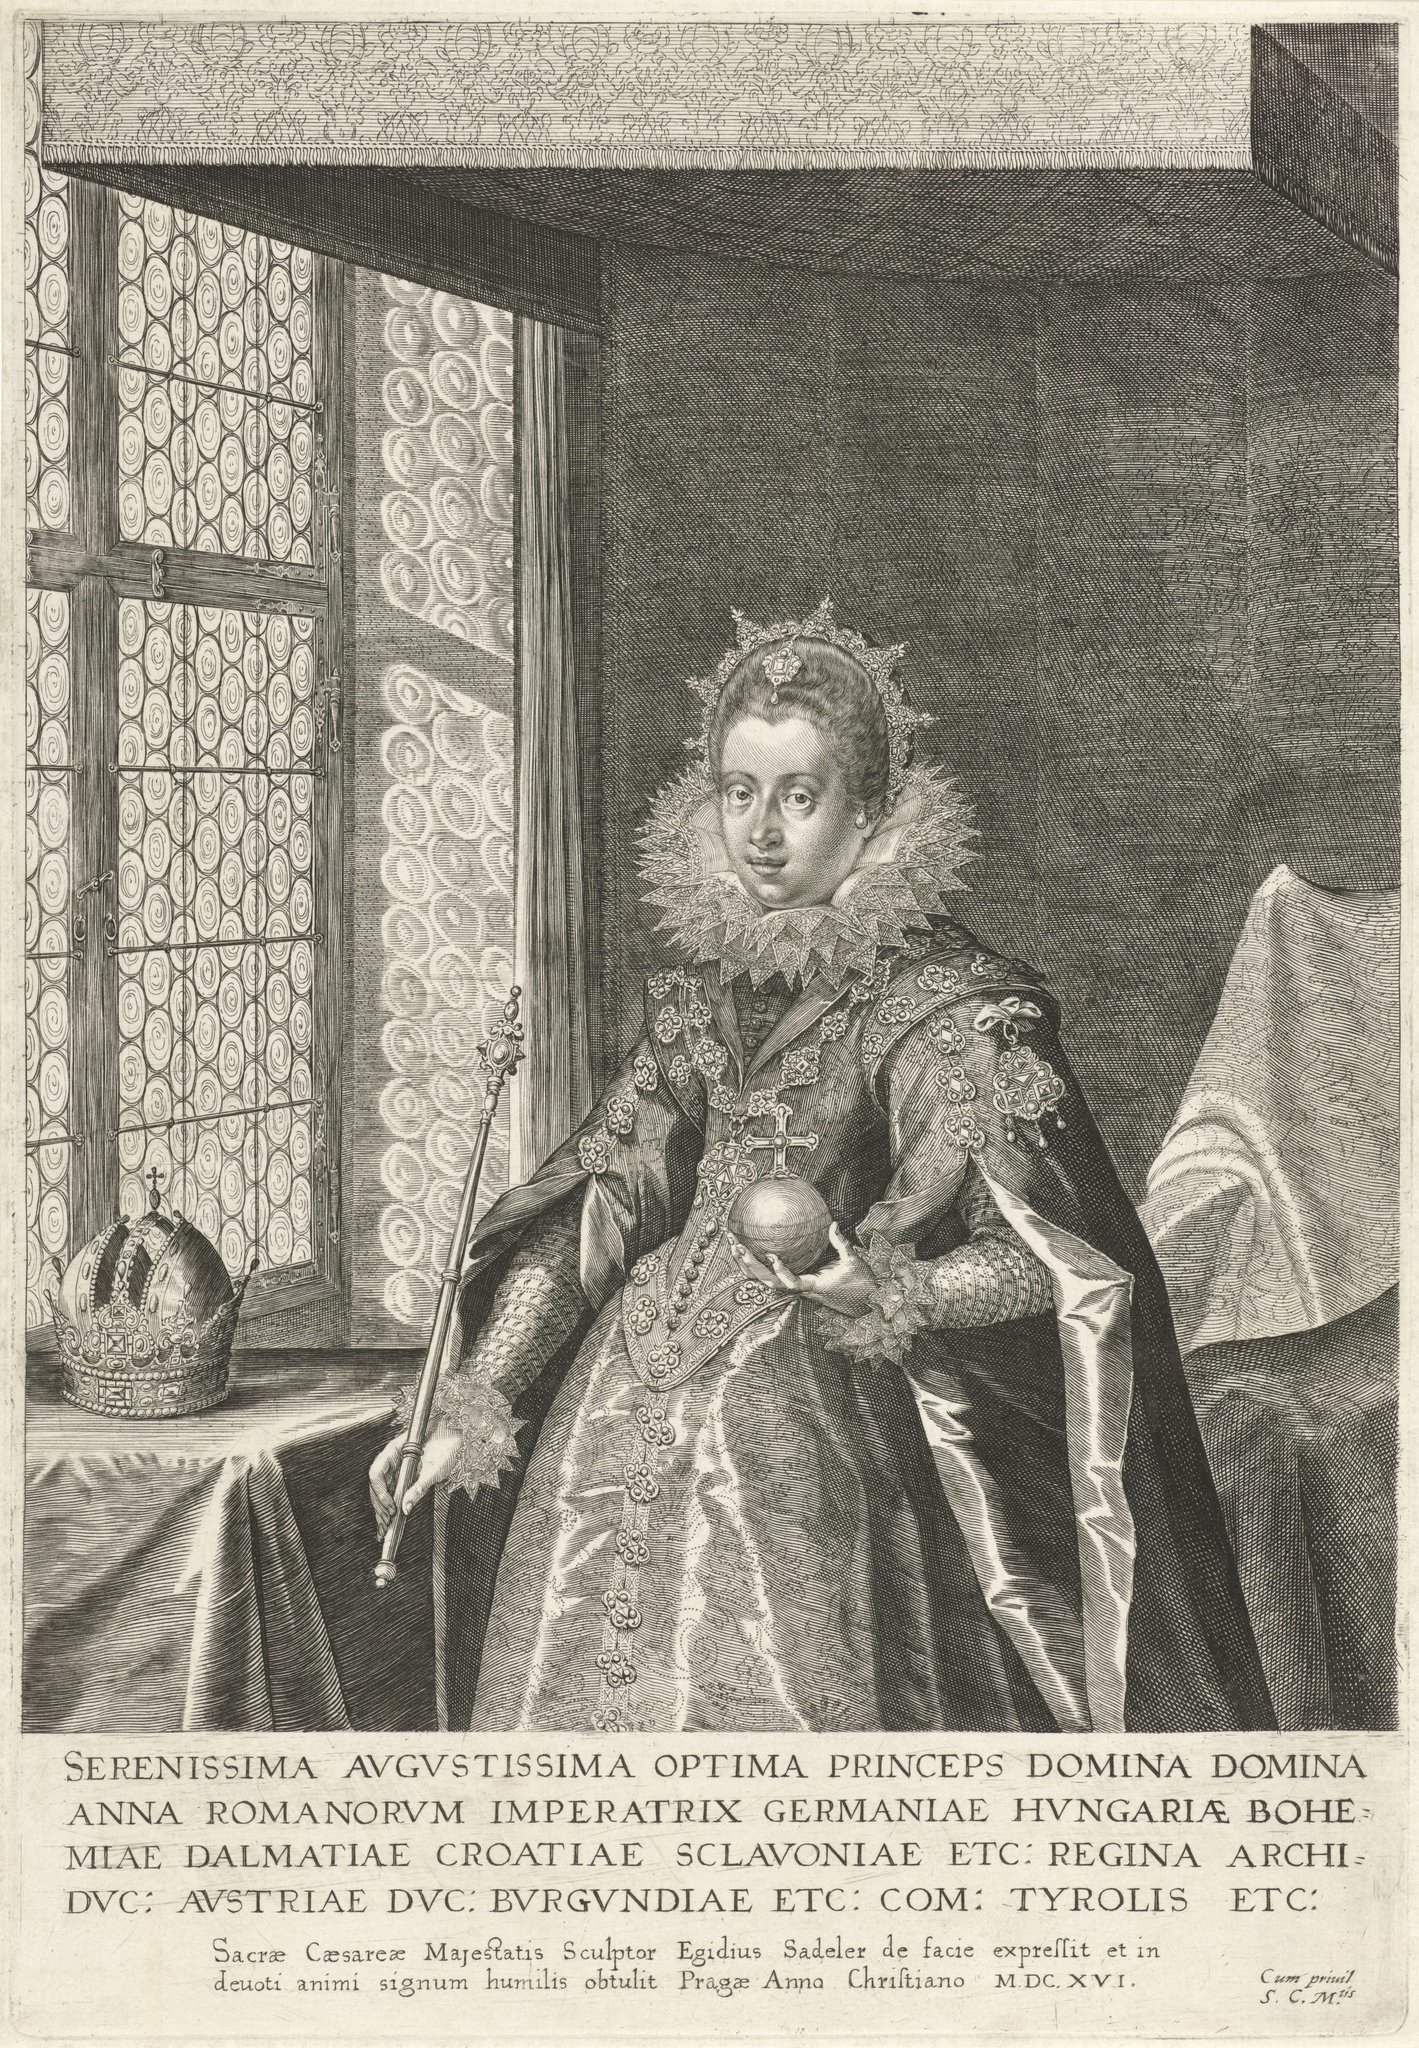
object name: print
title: Portret van Anna van Tirol, echtgenote van keizer Matthias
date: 1616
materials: paper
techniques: engraving, etching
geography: prague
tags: vienna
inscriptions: collector's mark: Lugt 240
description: Anna van Tirol, echtgenote van keizer Matthias van Oostenrijk. Ze staat naast een tafel waarop de keizerlijke kroon. De prent heeft een Latijns opschrift